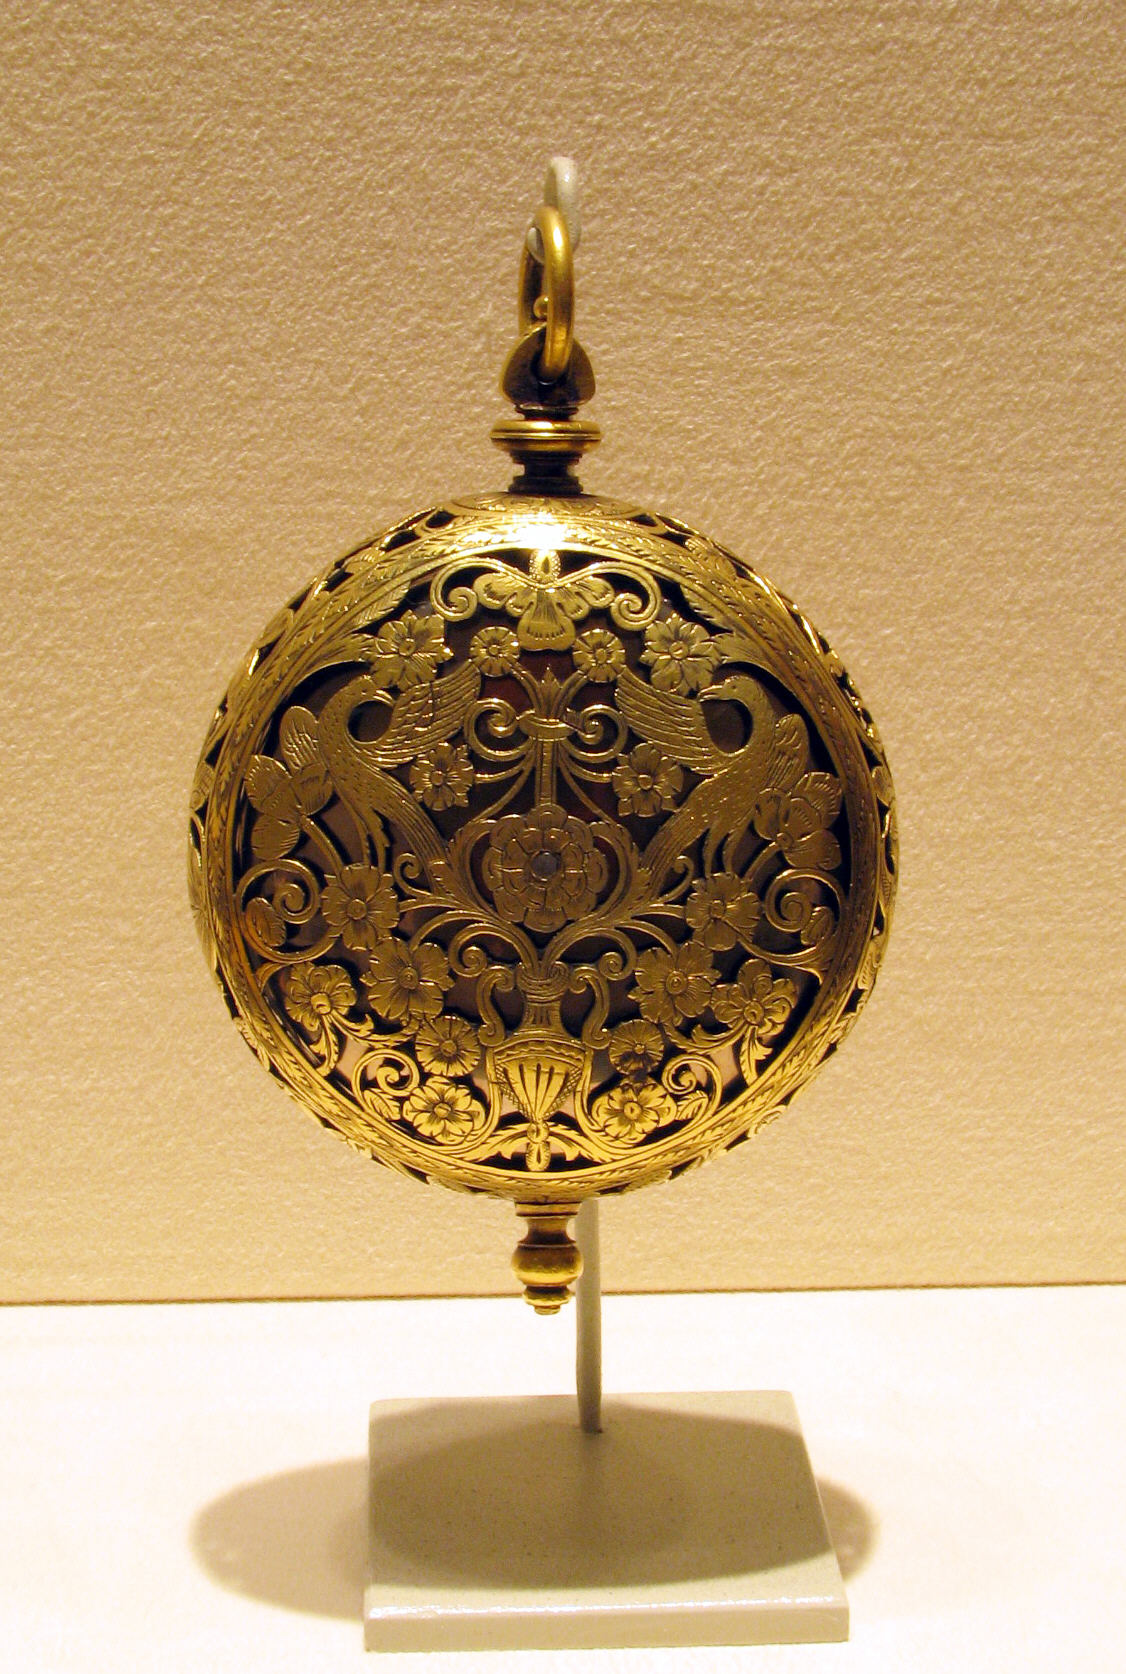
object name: repeater watch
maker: johann wutky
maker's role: maker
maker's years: 1660-1720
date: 1675-1680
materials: brass, silver, steel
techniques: incising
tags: birds,flowers